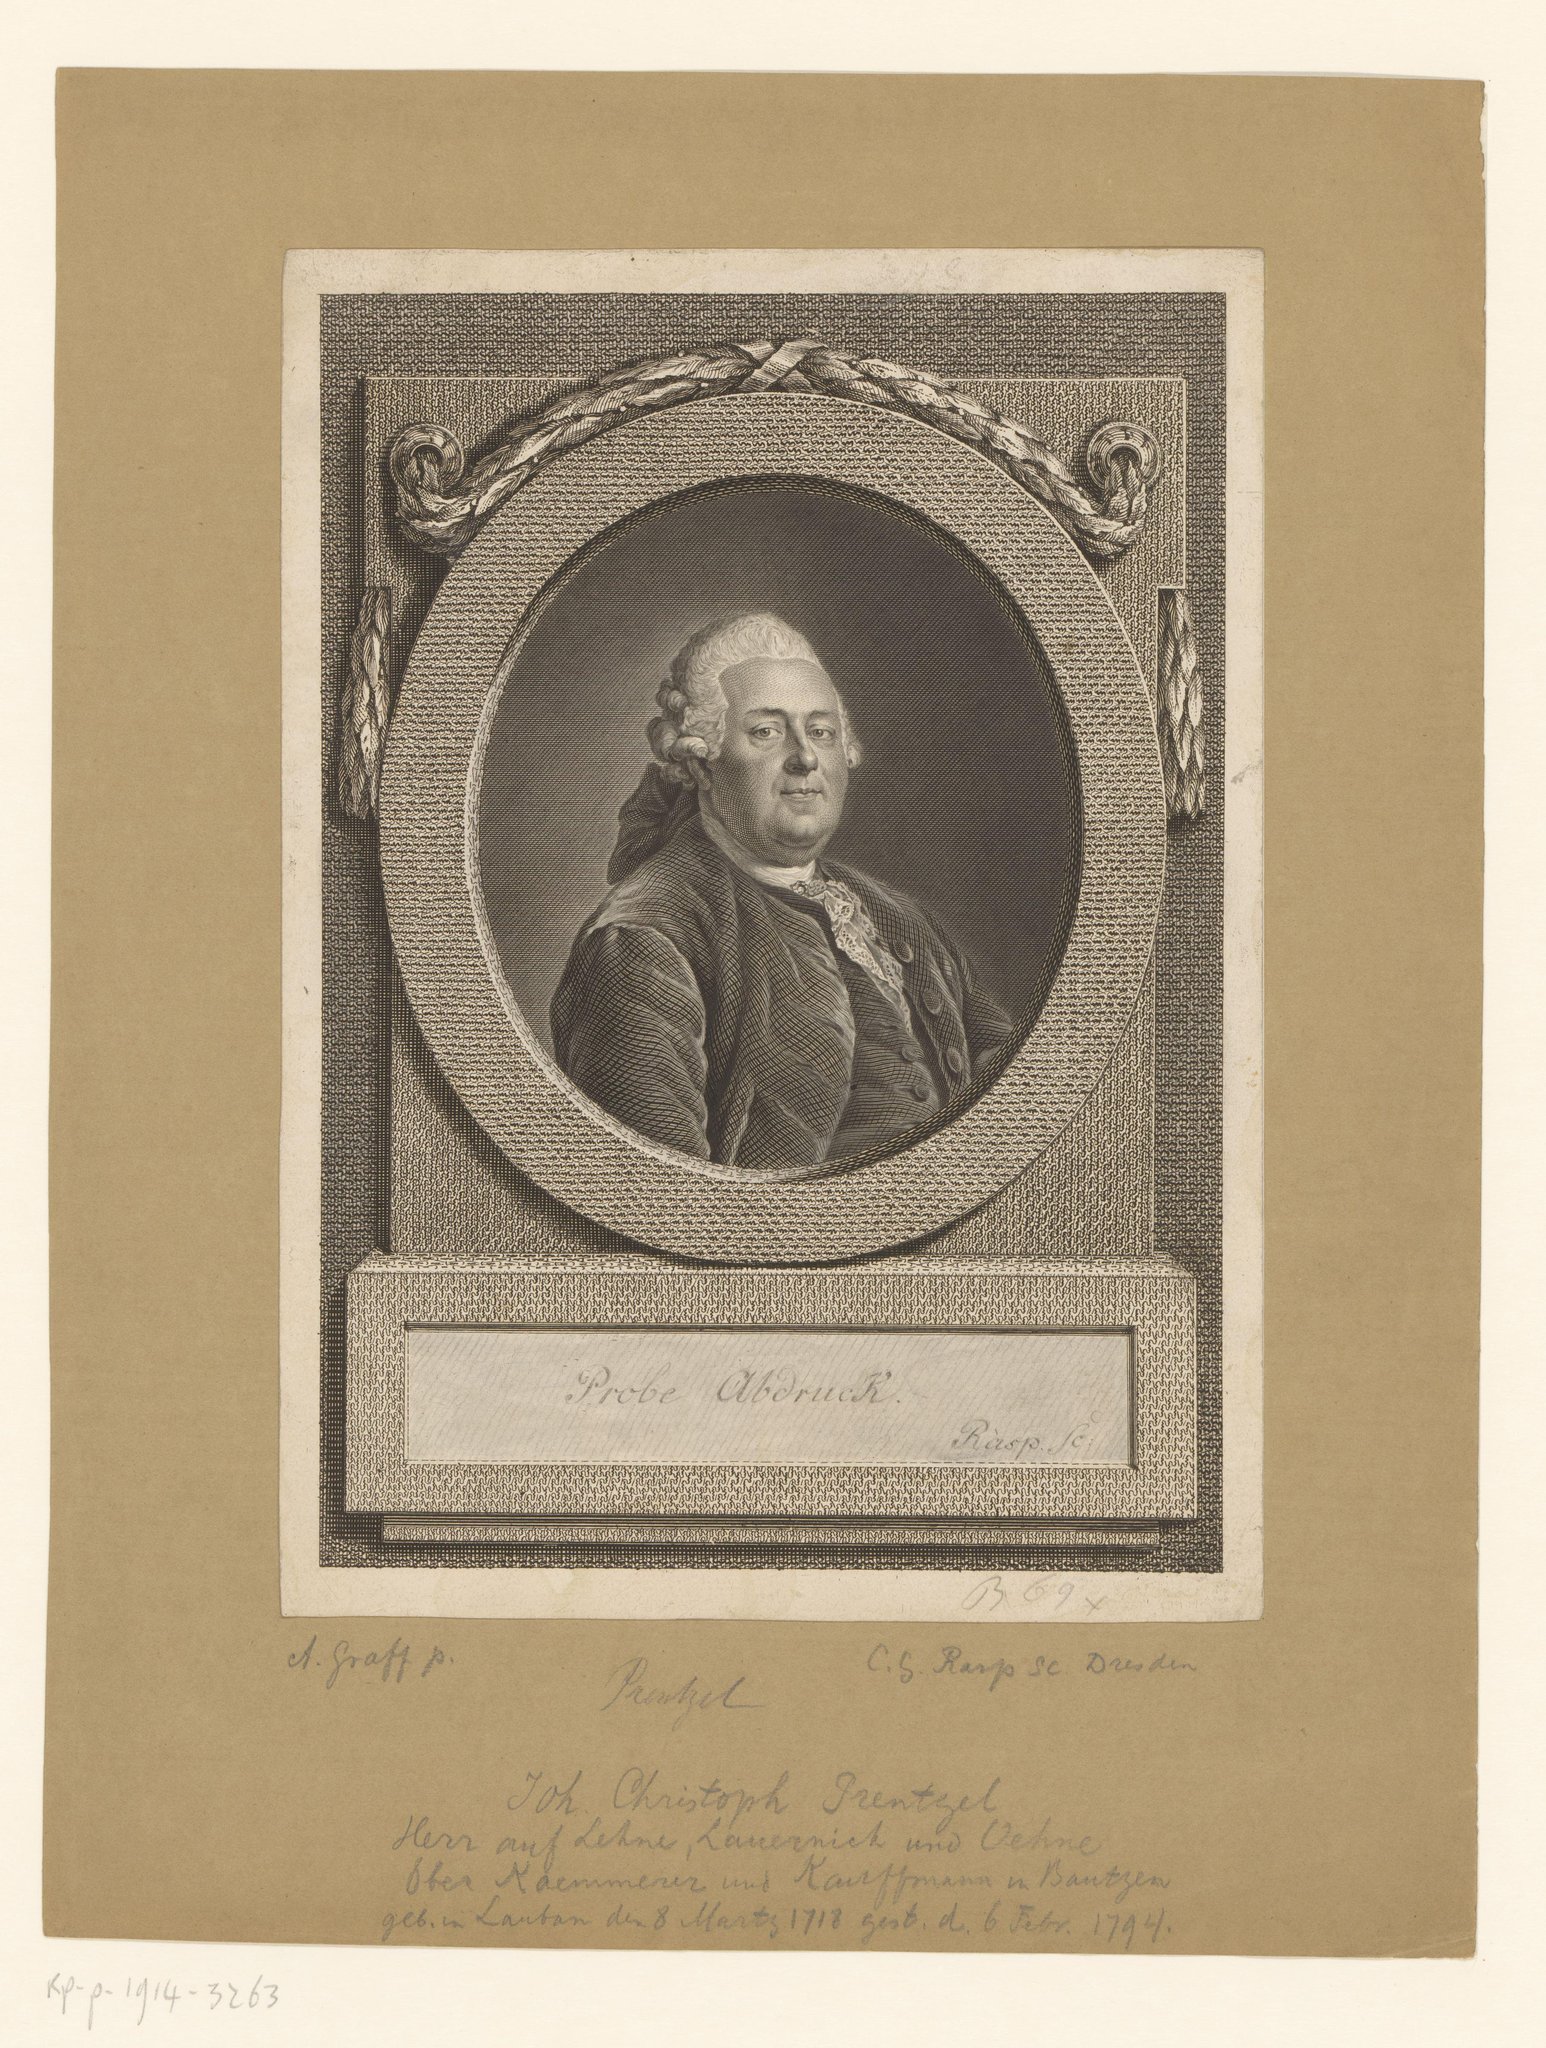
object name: print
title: Portret van Johann Christoph Prentzel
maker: carl gottlieb rasp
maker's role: print maker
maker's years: 1752-1807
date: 1794-1807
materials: paper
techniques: engraving, hand coloring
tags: historical persons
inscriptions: collector's mark: Lugt 2228, : ‘Probe Abdruck Rasp sc.’